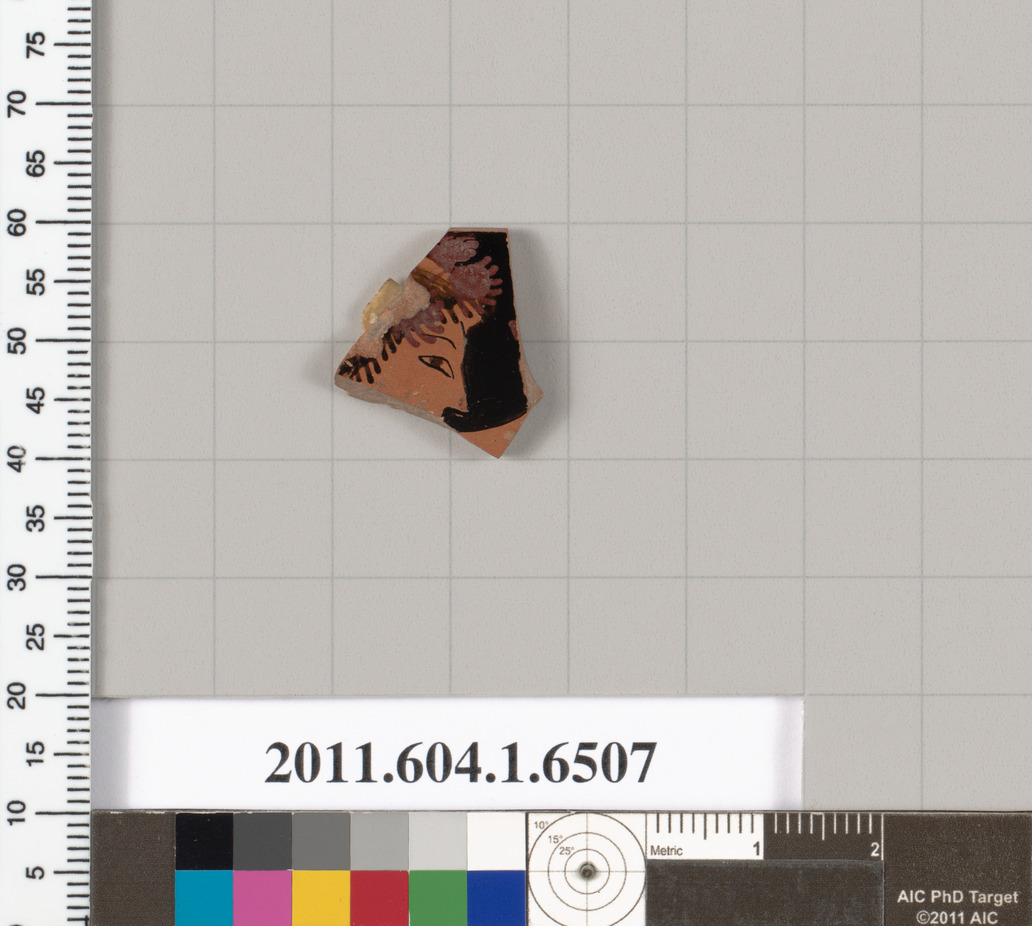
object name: kylix fragment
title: Terracotta rim fragment of a kylix (drinking cup)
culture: greek, attic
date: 490-480 BCE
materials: terracotta